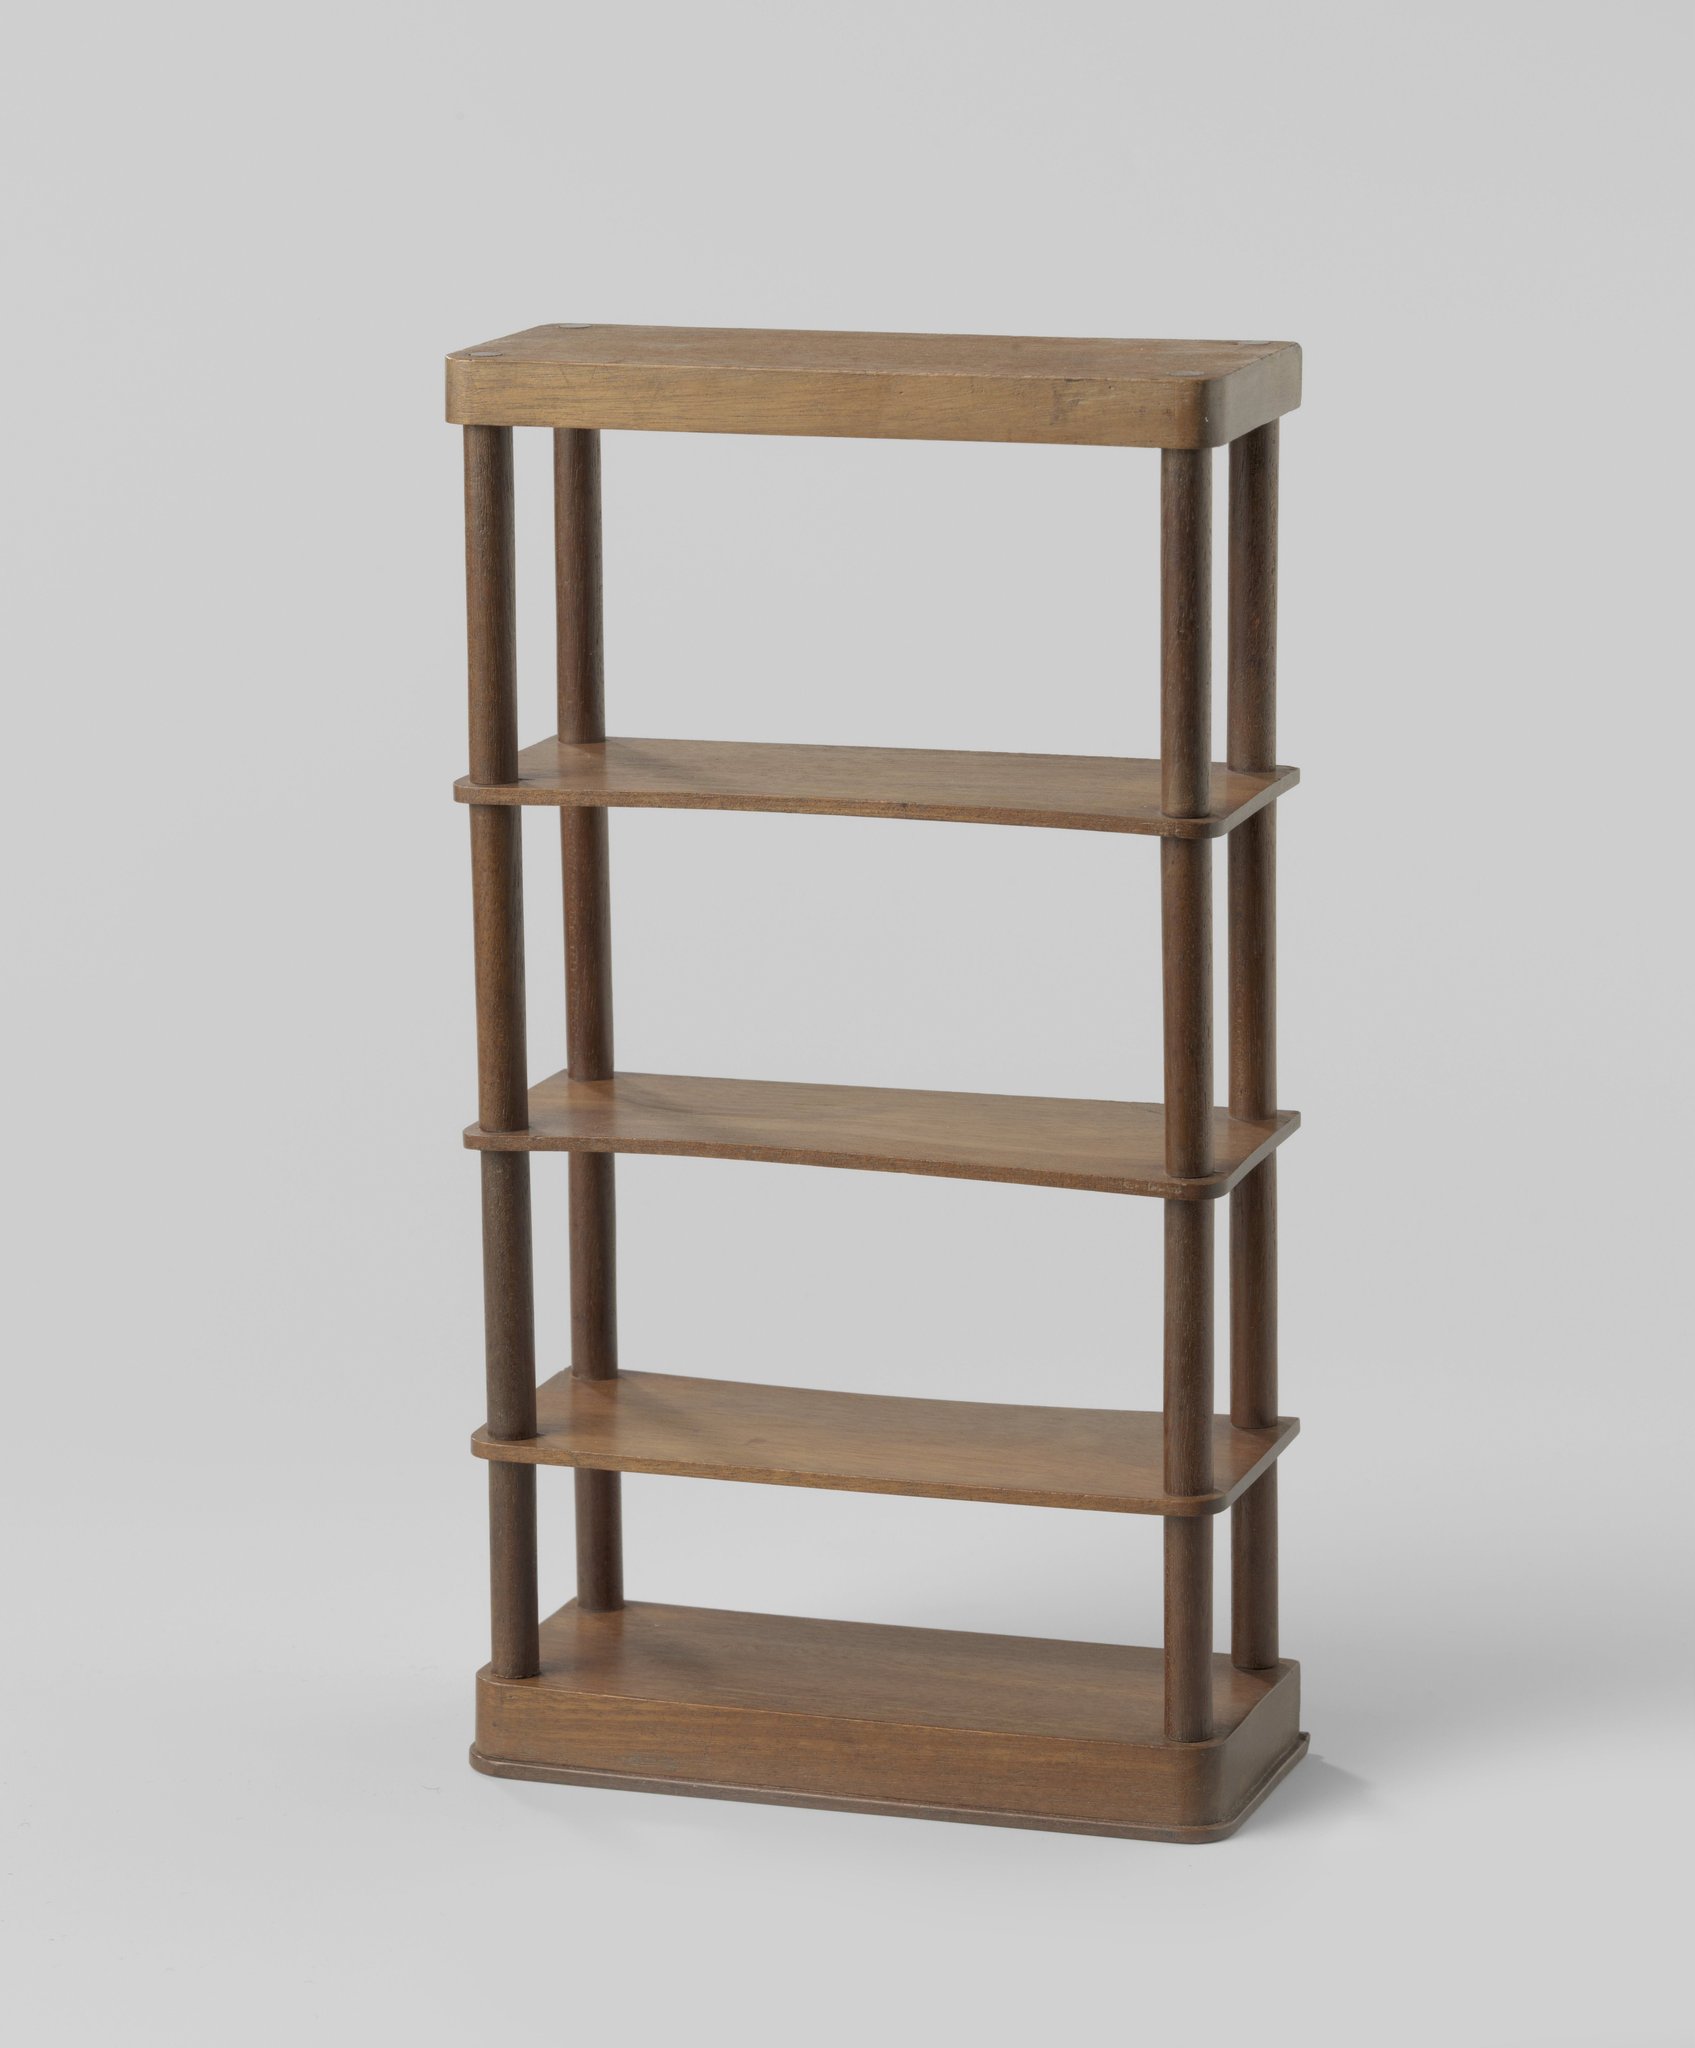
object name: case furniture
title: Stellingkast met drie planken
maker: Anonymous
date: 1820-1840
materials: wood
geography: amsterdam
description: Stellingkast van mahoniehout, bestaande uit zware massieve plint, drie dunne planken en een massieve kap met dekplaat, onderling verbonden door ronde gladde stijlen.